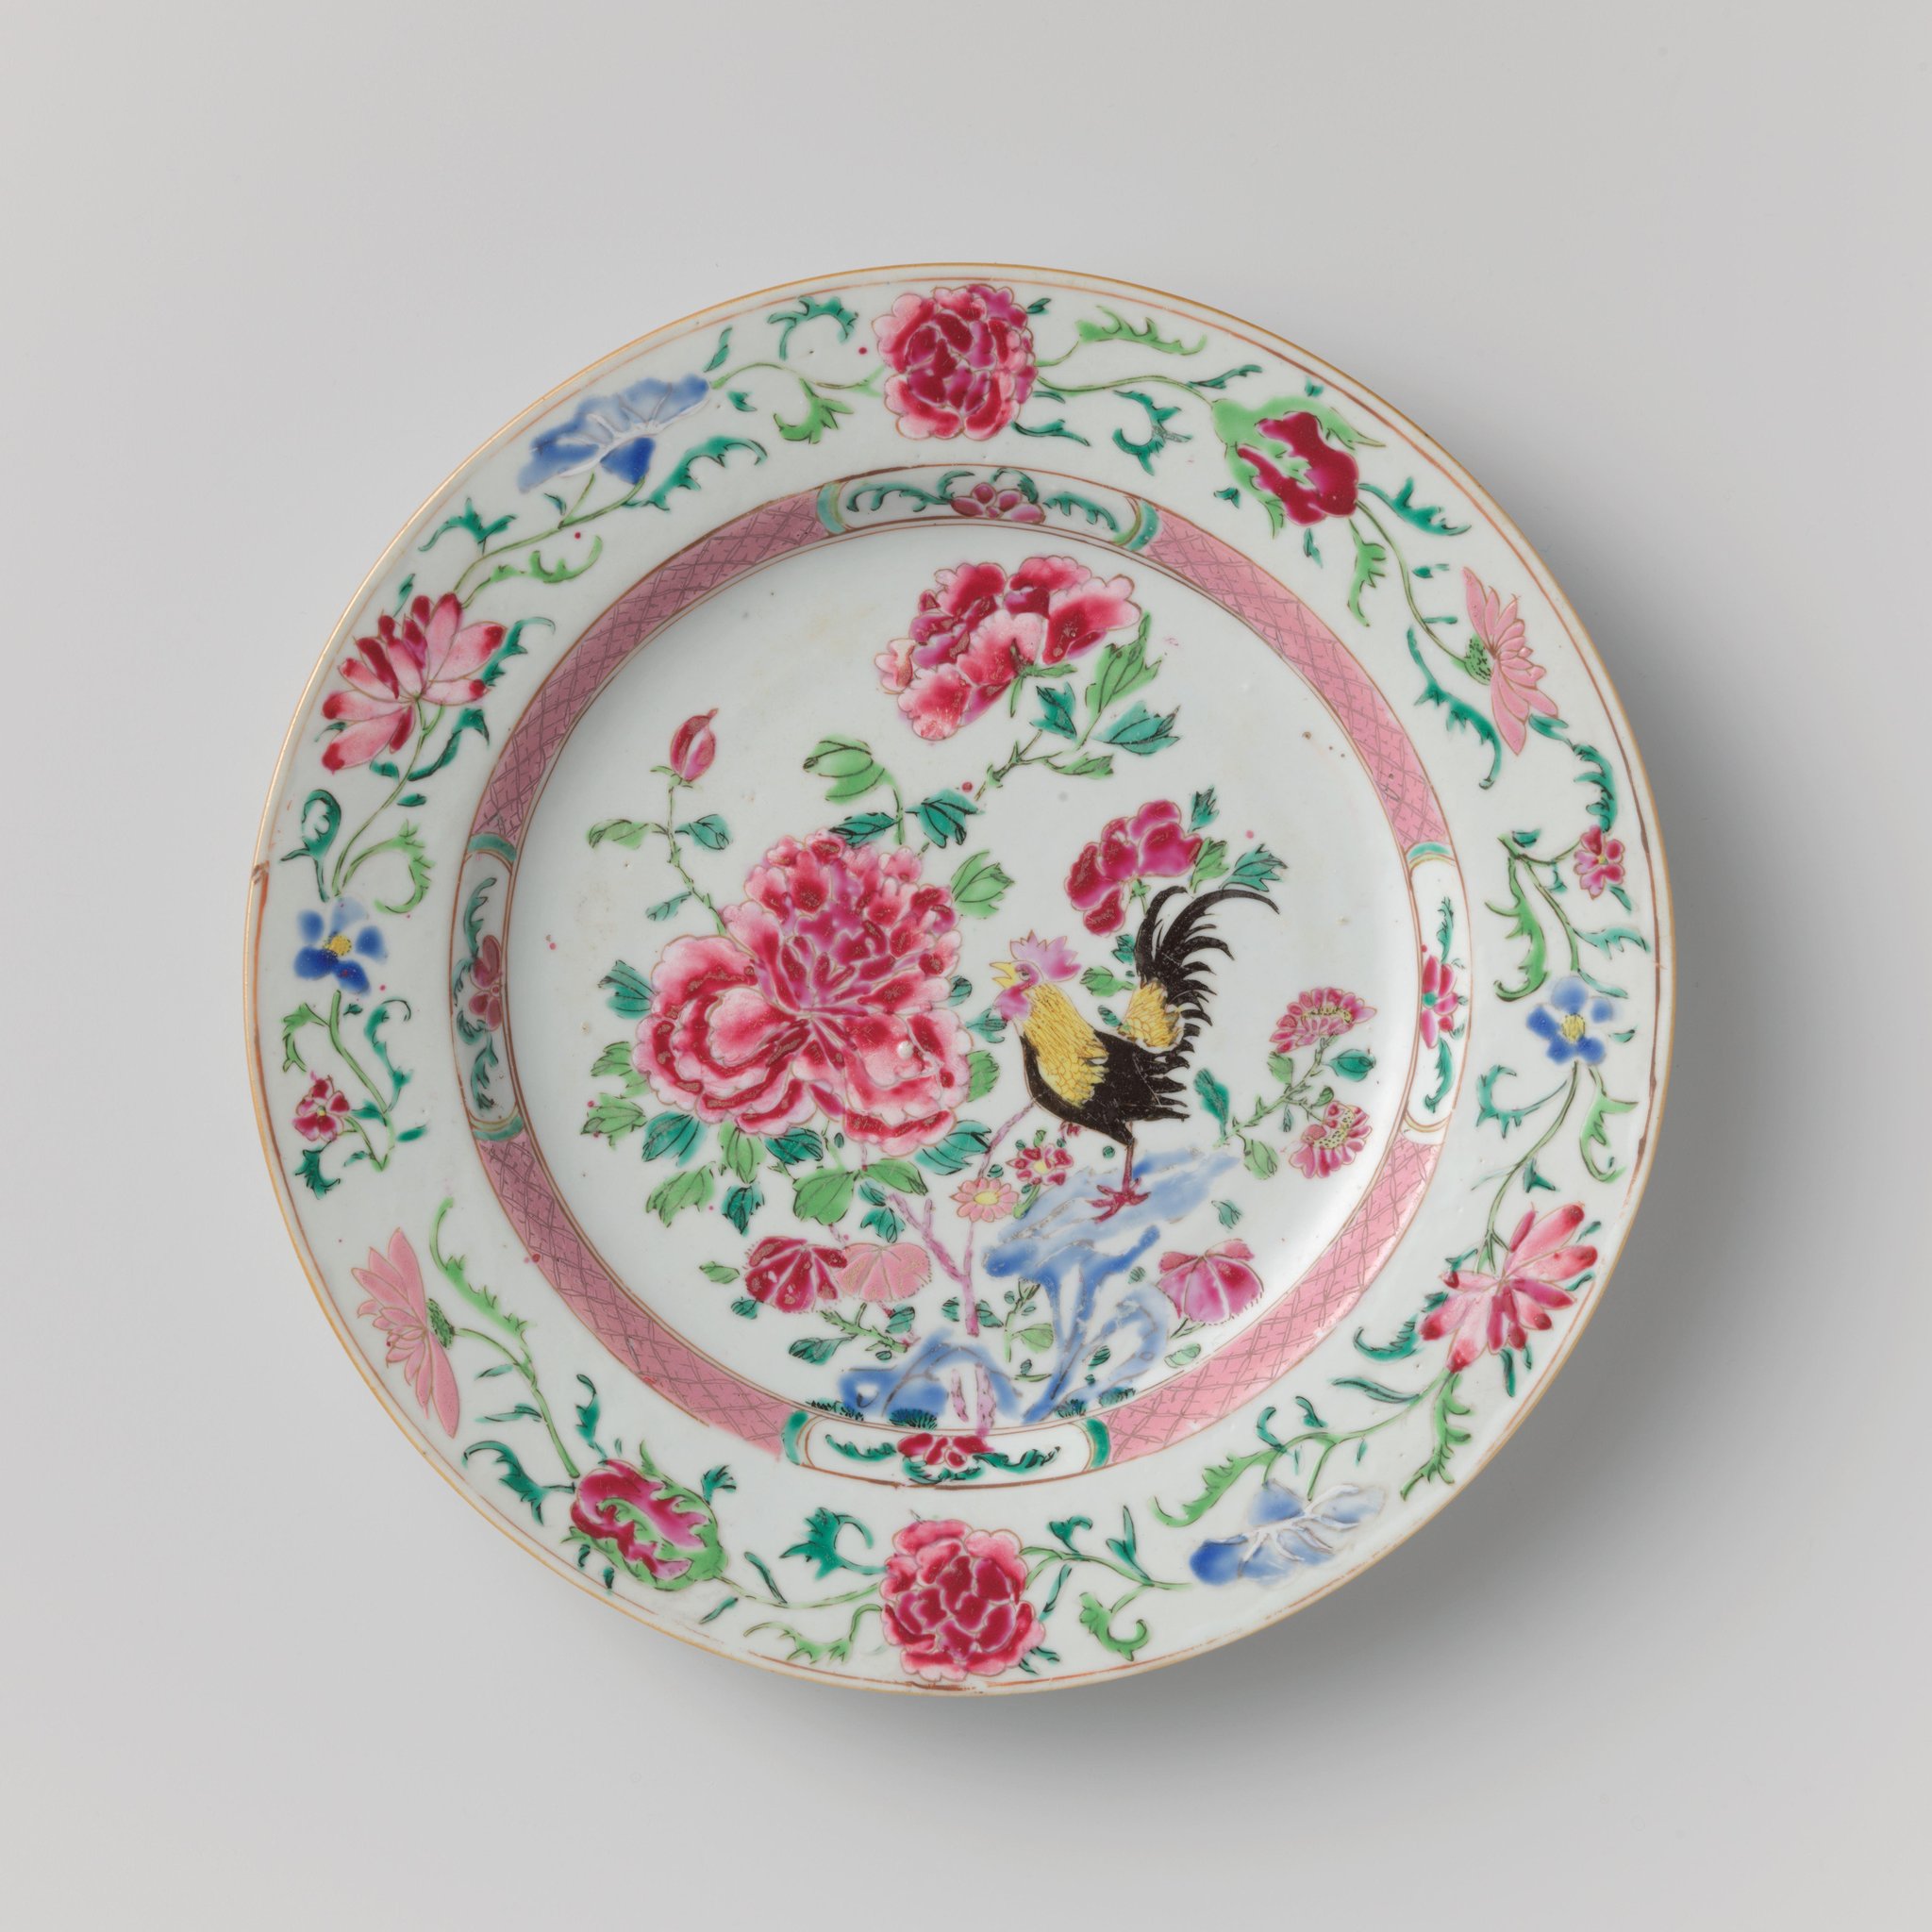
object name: plate dish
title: Plate with a cock on a rock near flowering plants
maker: Anonymous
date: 1725-1749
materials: glaze, paint, porcelain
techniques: firing, turning, vitrification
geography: china